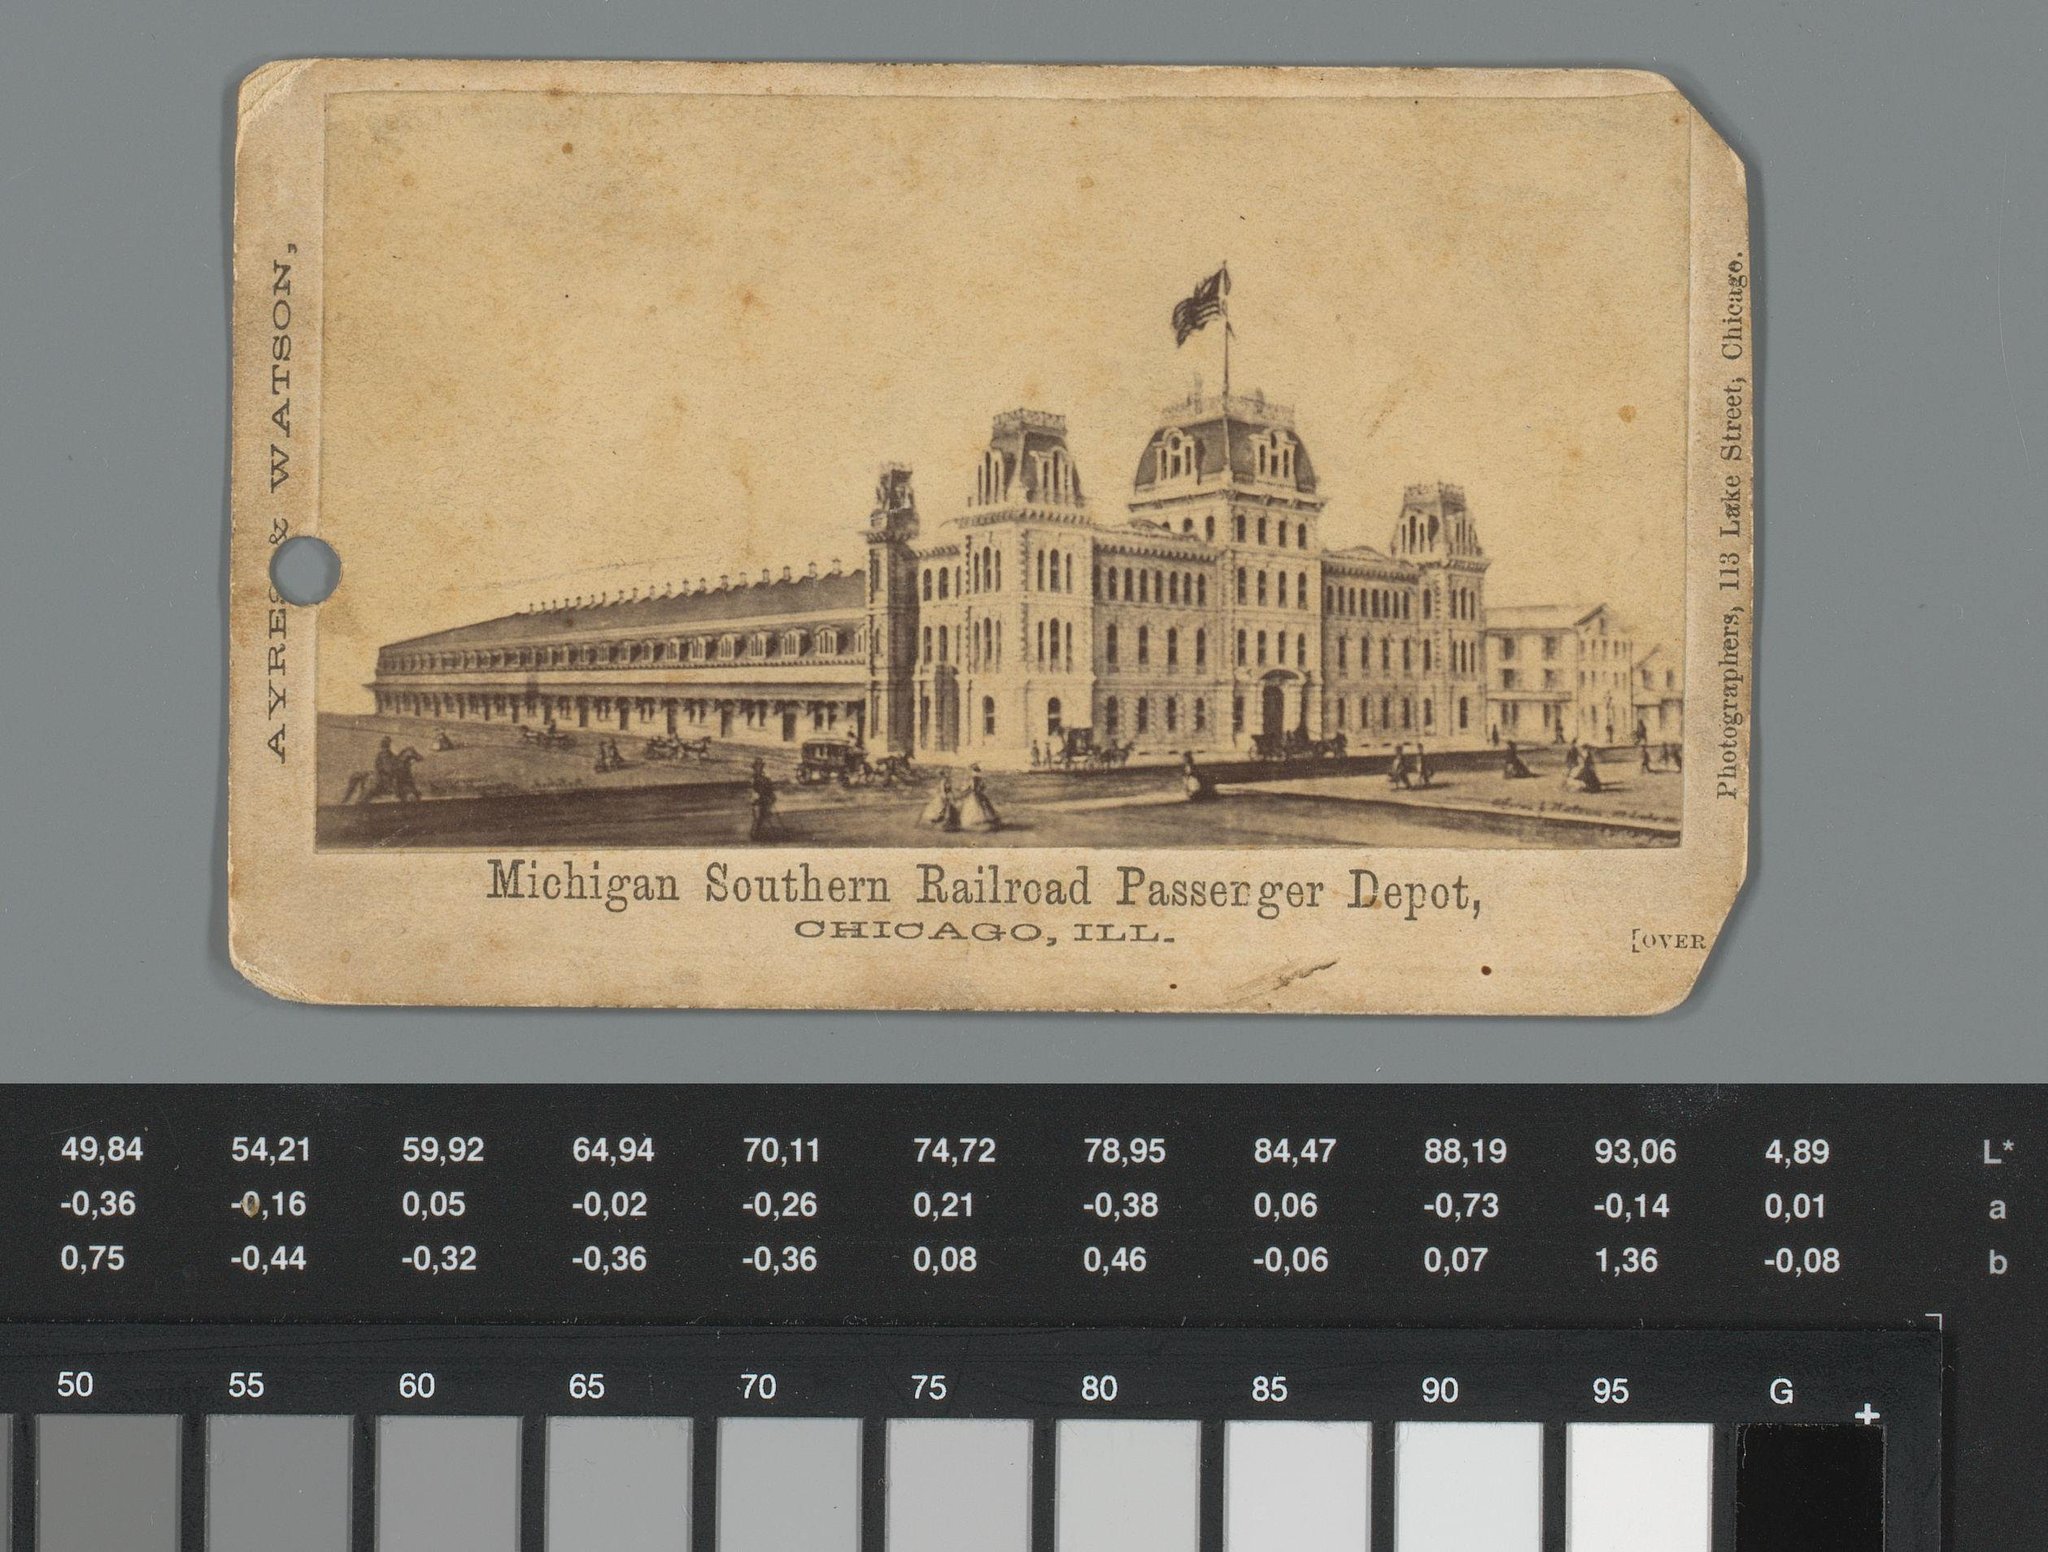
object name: photograph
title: Michigan Southern Railroad Passenger Depot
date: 1873-1915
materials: cardboard, photographic support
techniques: albumen print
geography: chicago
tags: railway-traffic, advertising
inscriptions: address: ‘AYRES & WATSON,/ Photographers, 113 Lake Street, Chicago.’, inscription: ‘(...)’